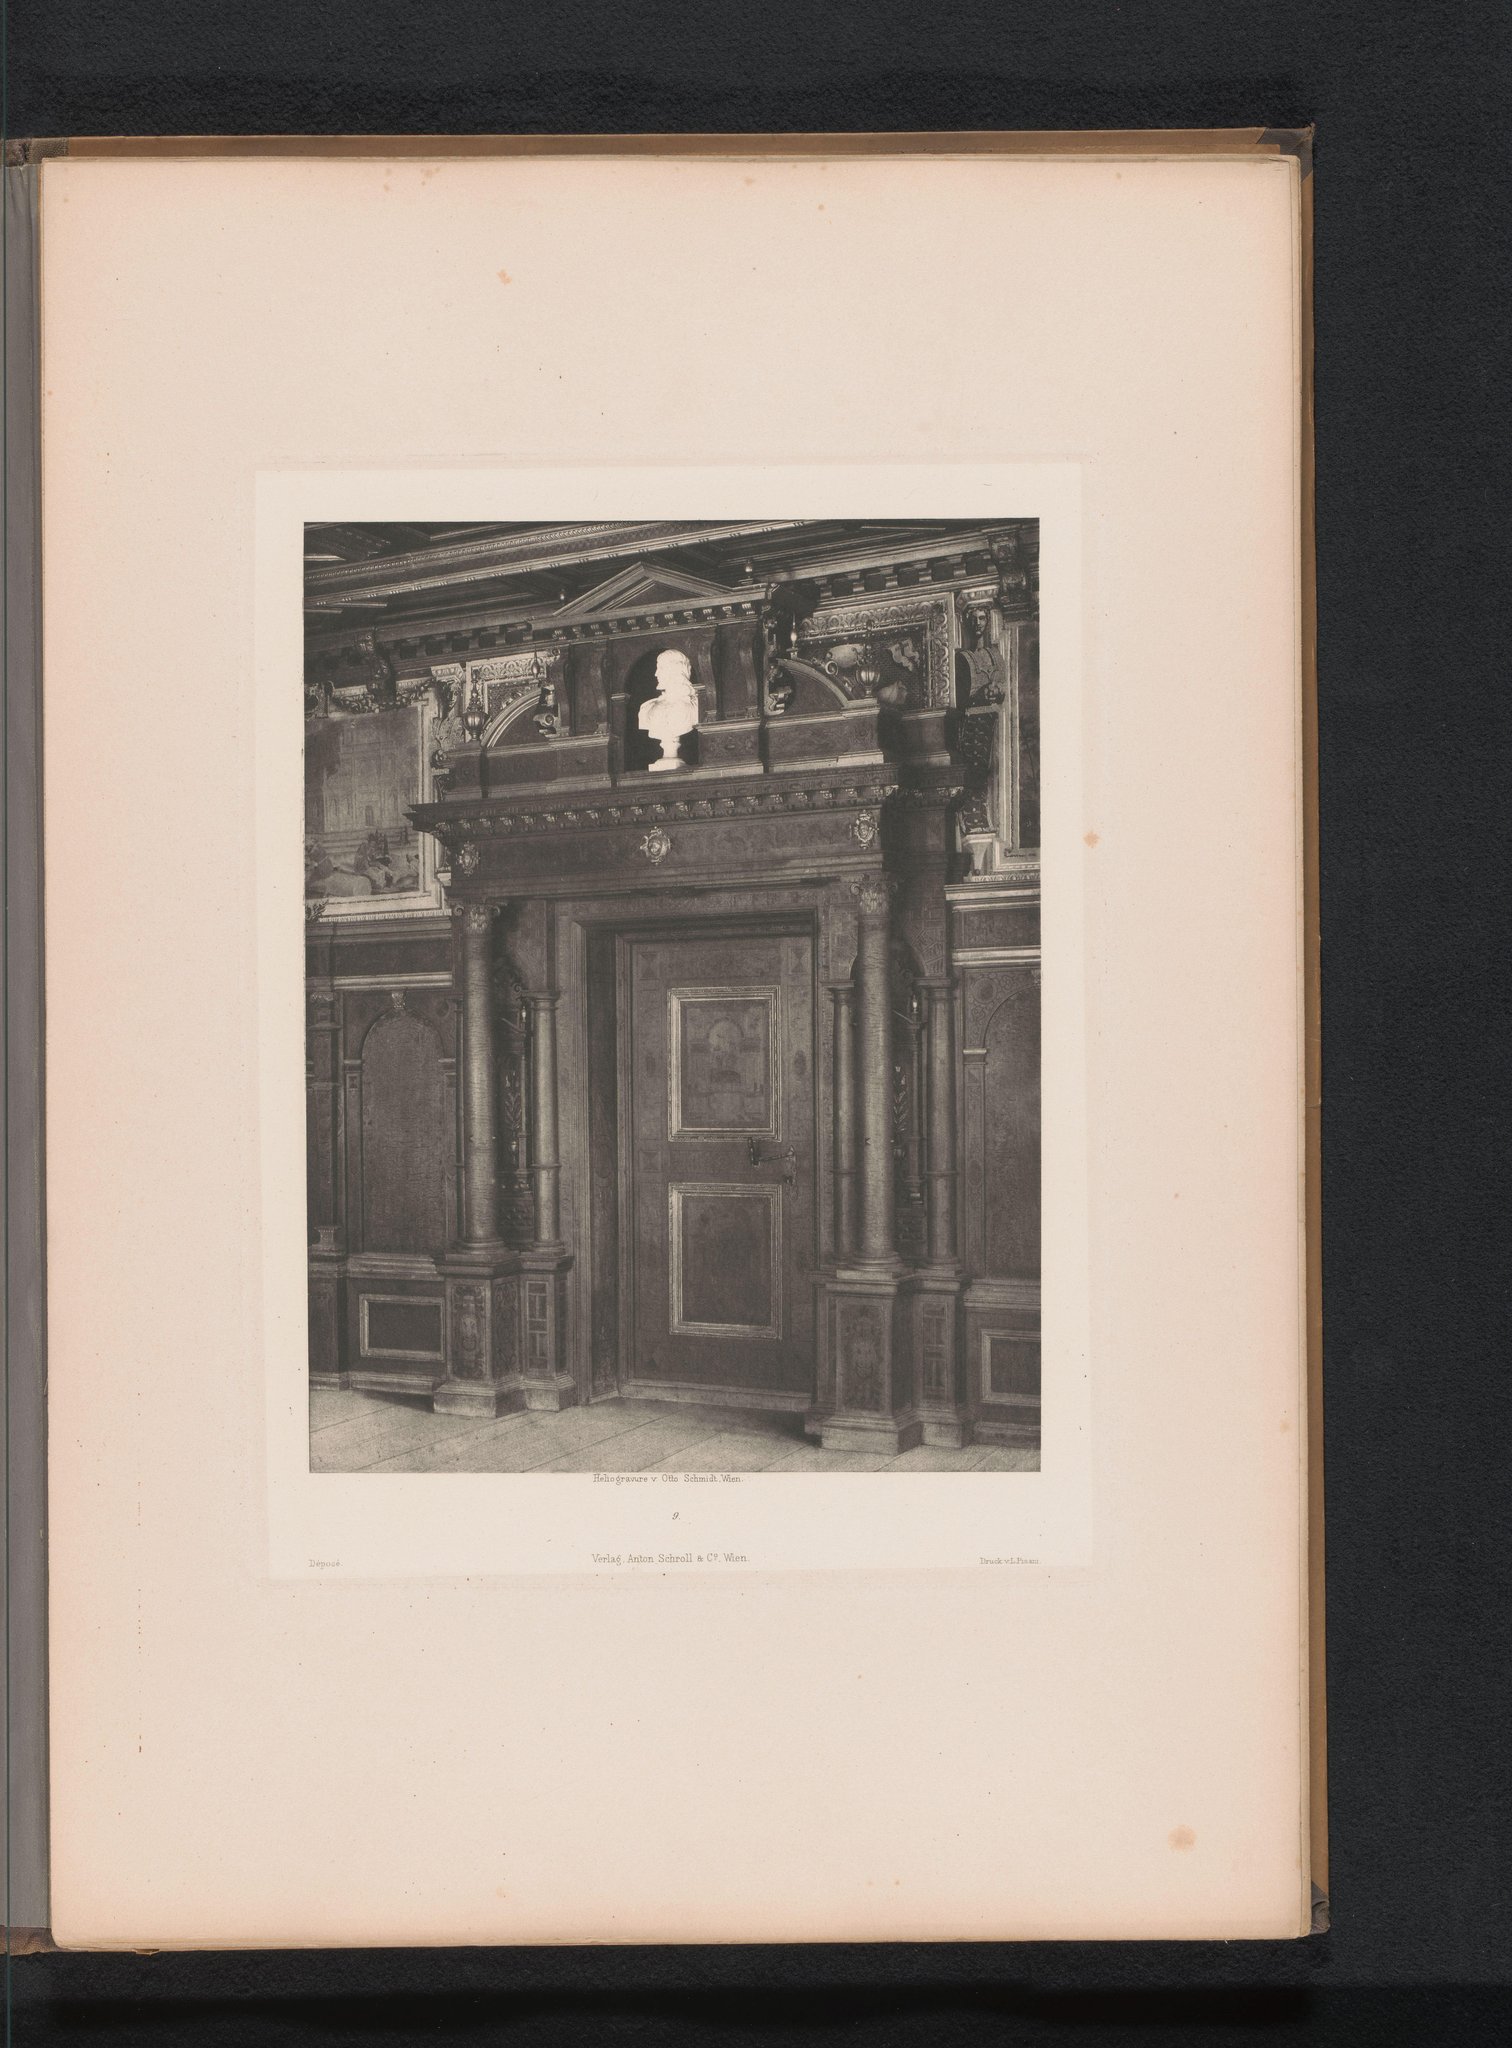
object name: photomechanical print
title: Gezicht op een deur in de Fürstenzimmer van Slot Velthurns bij Bressanone, Italië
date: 1886-1891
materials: paper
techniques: photoaquatint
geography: slot velthurns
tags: castle - aa - civic architecture: inside, closed door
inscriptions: number: ‘9.’, inscription: ‘Déposé.’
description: Deze prent maakt deel uit van een omslag met dertig prenten en drie tekstbladen.